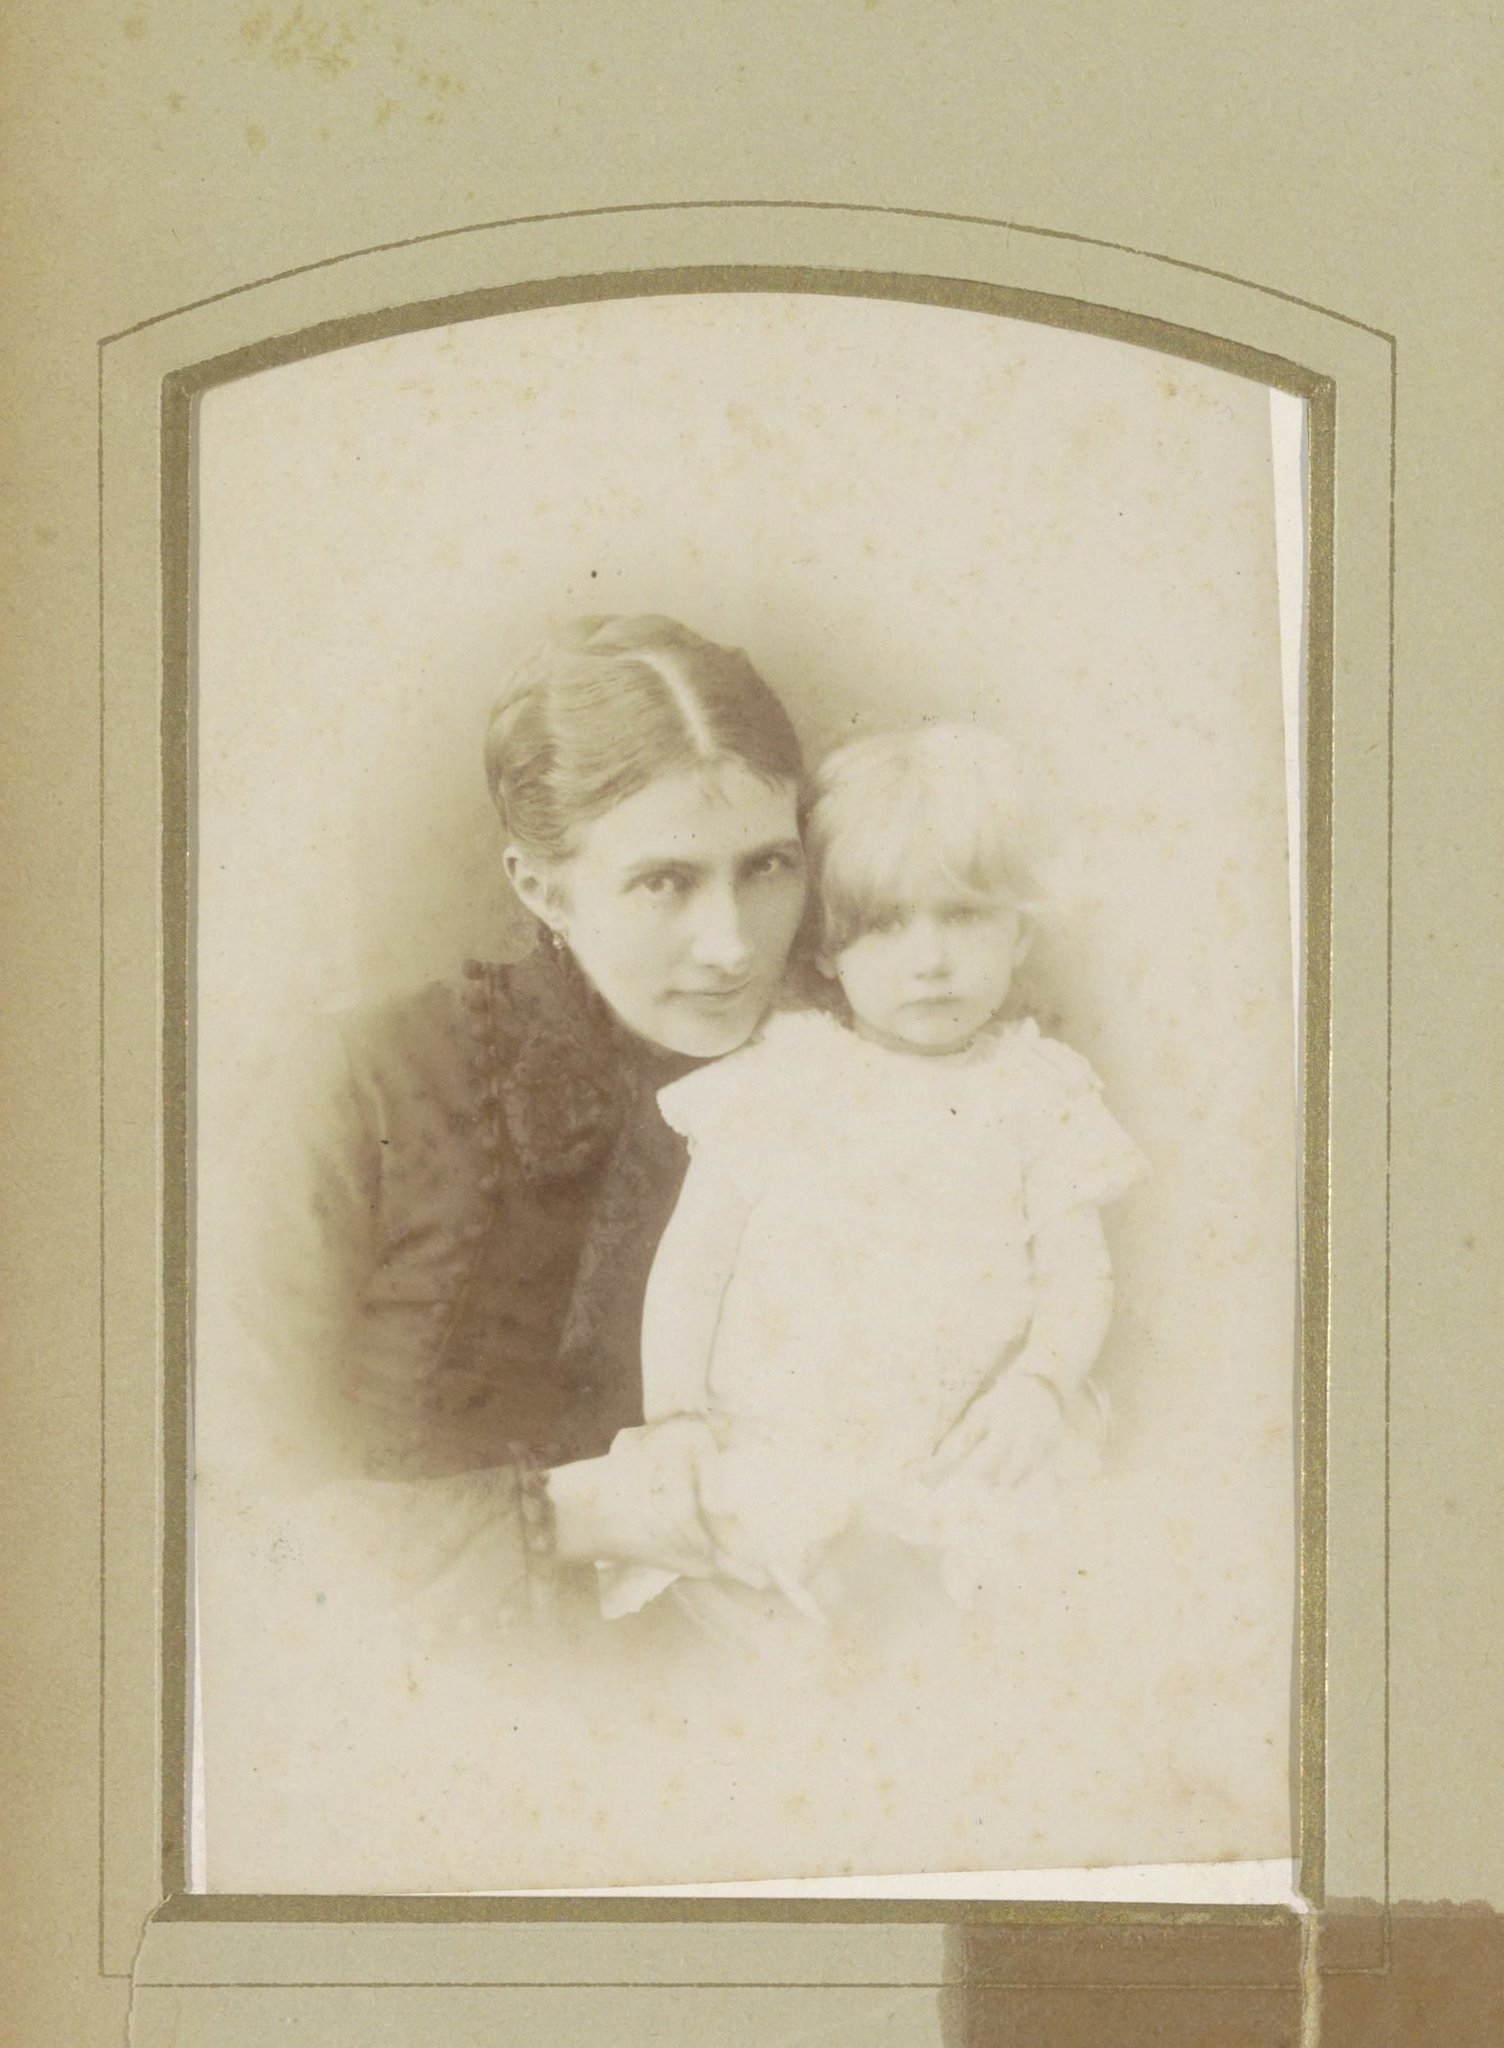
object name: photograph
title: Portret van Eva en Jet Boelen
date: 1875-1899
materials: cardboard, paper, photographic support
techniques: albumen print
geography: amsterdam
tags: historical persons - bb - woman, mother and baby or young child, amsterdam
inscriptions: address: ‘Warmoesstraat 147, Amsterdam.’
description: Onderdeel van Fotoalbum van de familie Boelen.